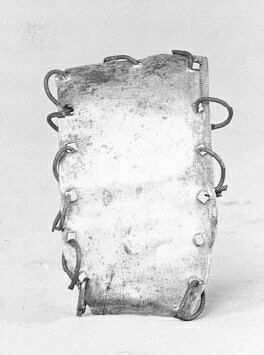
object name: rattle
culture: african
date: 1867-1900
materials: tin